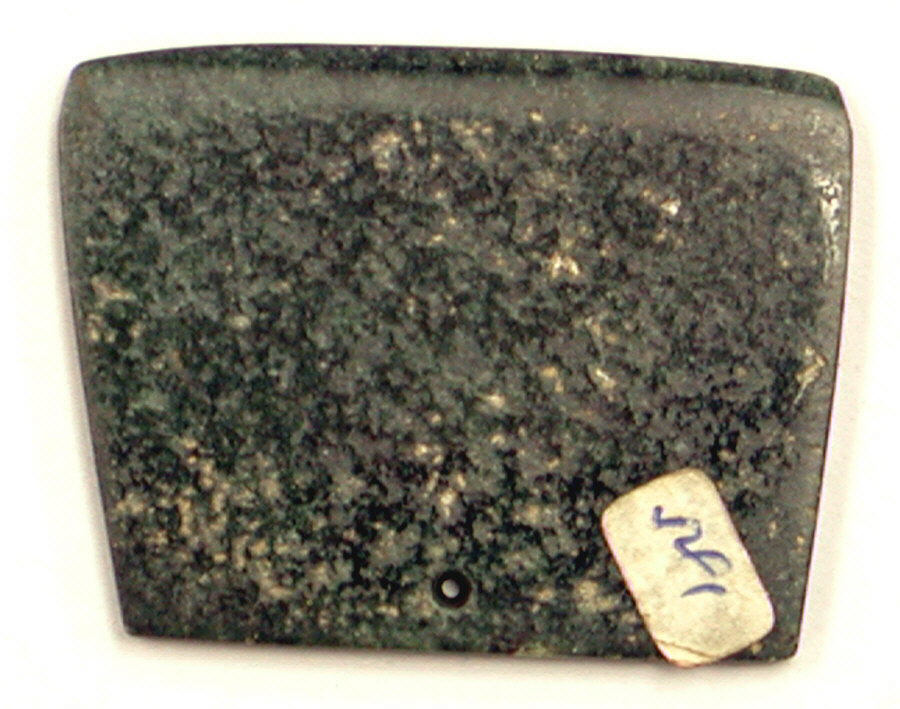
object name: pendant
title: Stone Pendant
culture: mexican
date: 1501-1600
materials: stone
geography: mexico